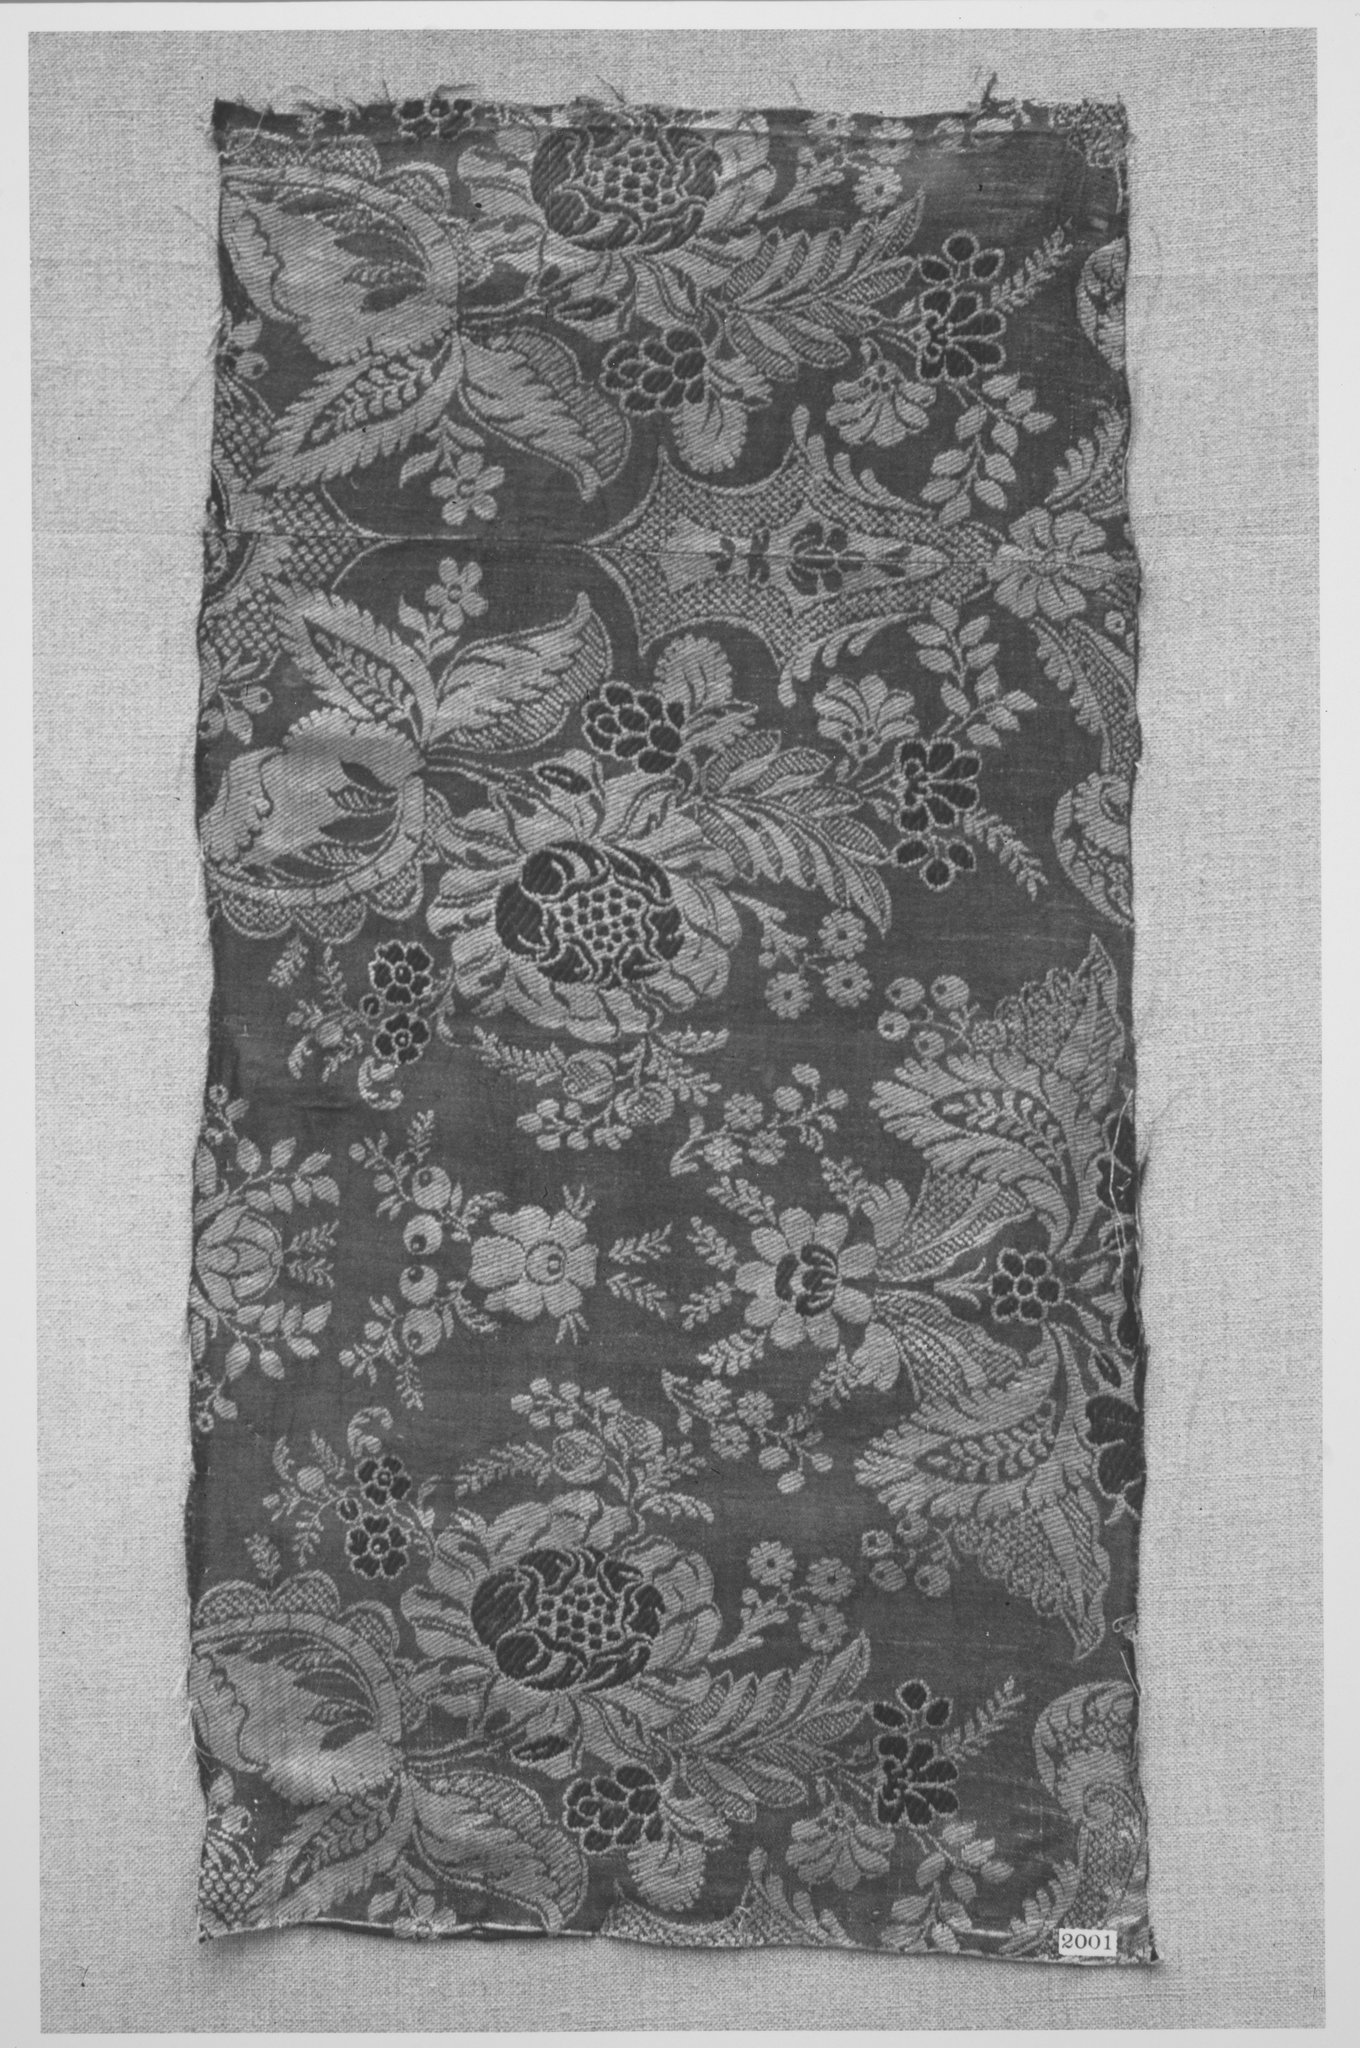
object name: piece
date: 1725-1730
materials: linen, silk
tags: flowers,leaves